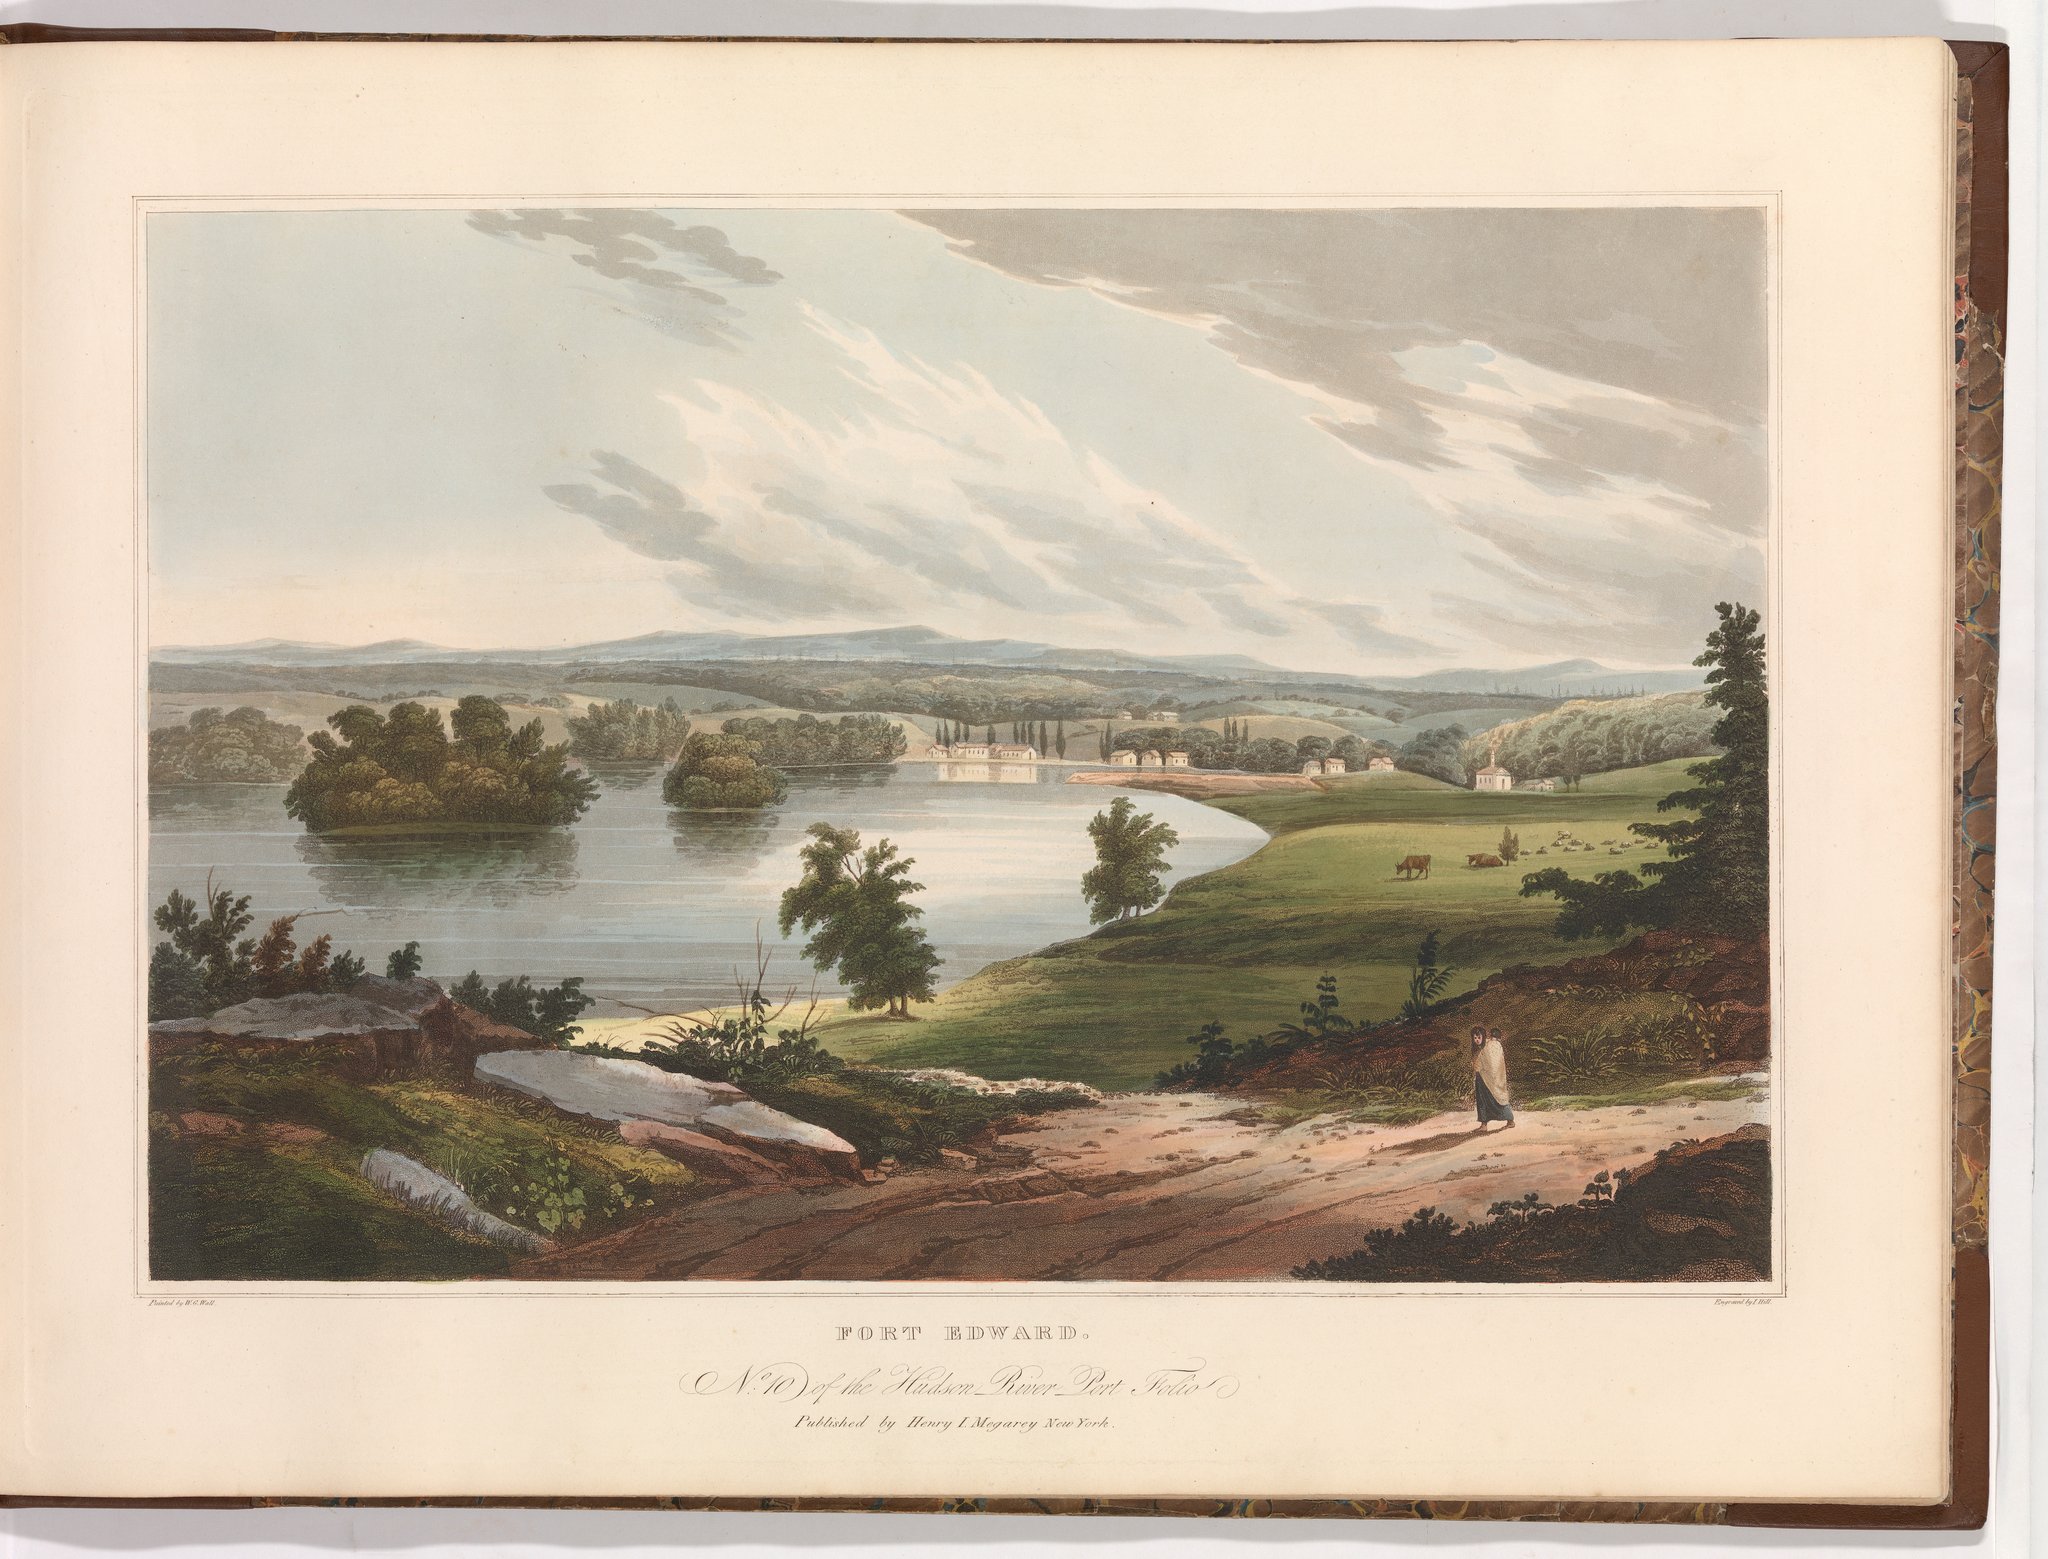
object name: print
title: Fort Edward (No. 10 of The Hudson River Portfolio)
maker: john hill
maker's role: etcher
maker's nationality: american, born england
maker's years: 1770-1850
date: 1822-1823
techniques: aquatint, hand coloring, printing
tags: men,landscapes,trees